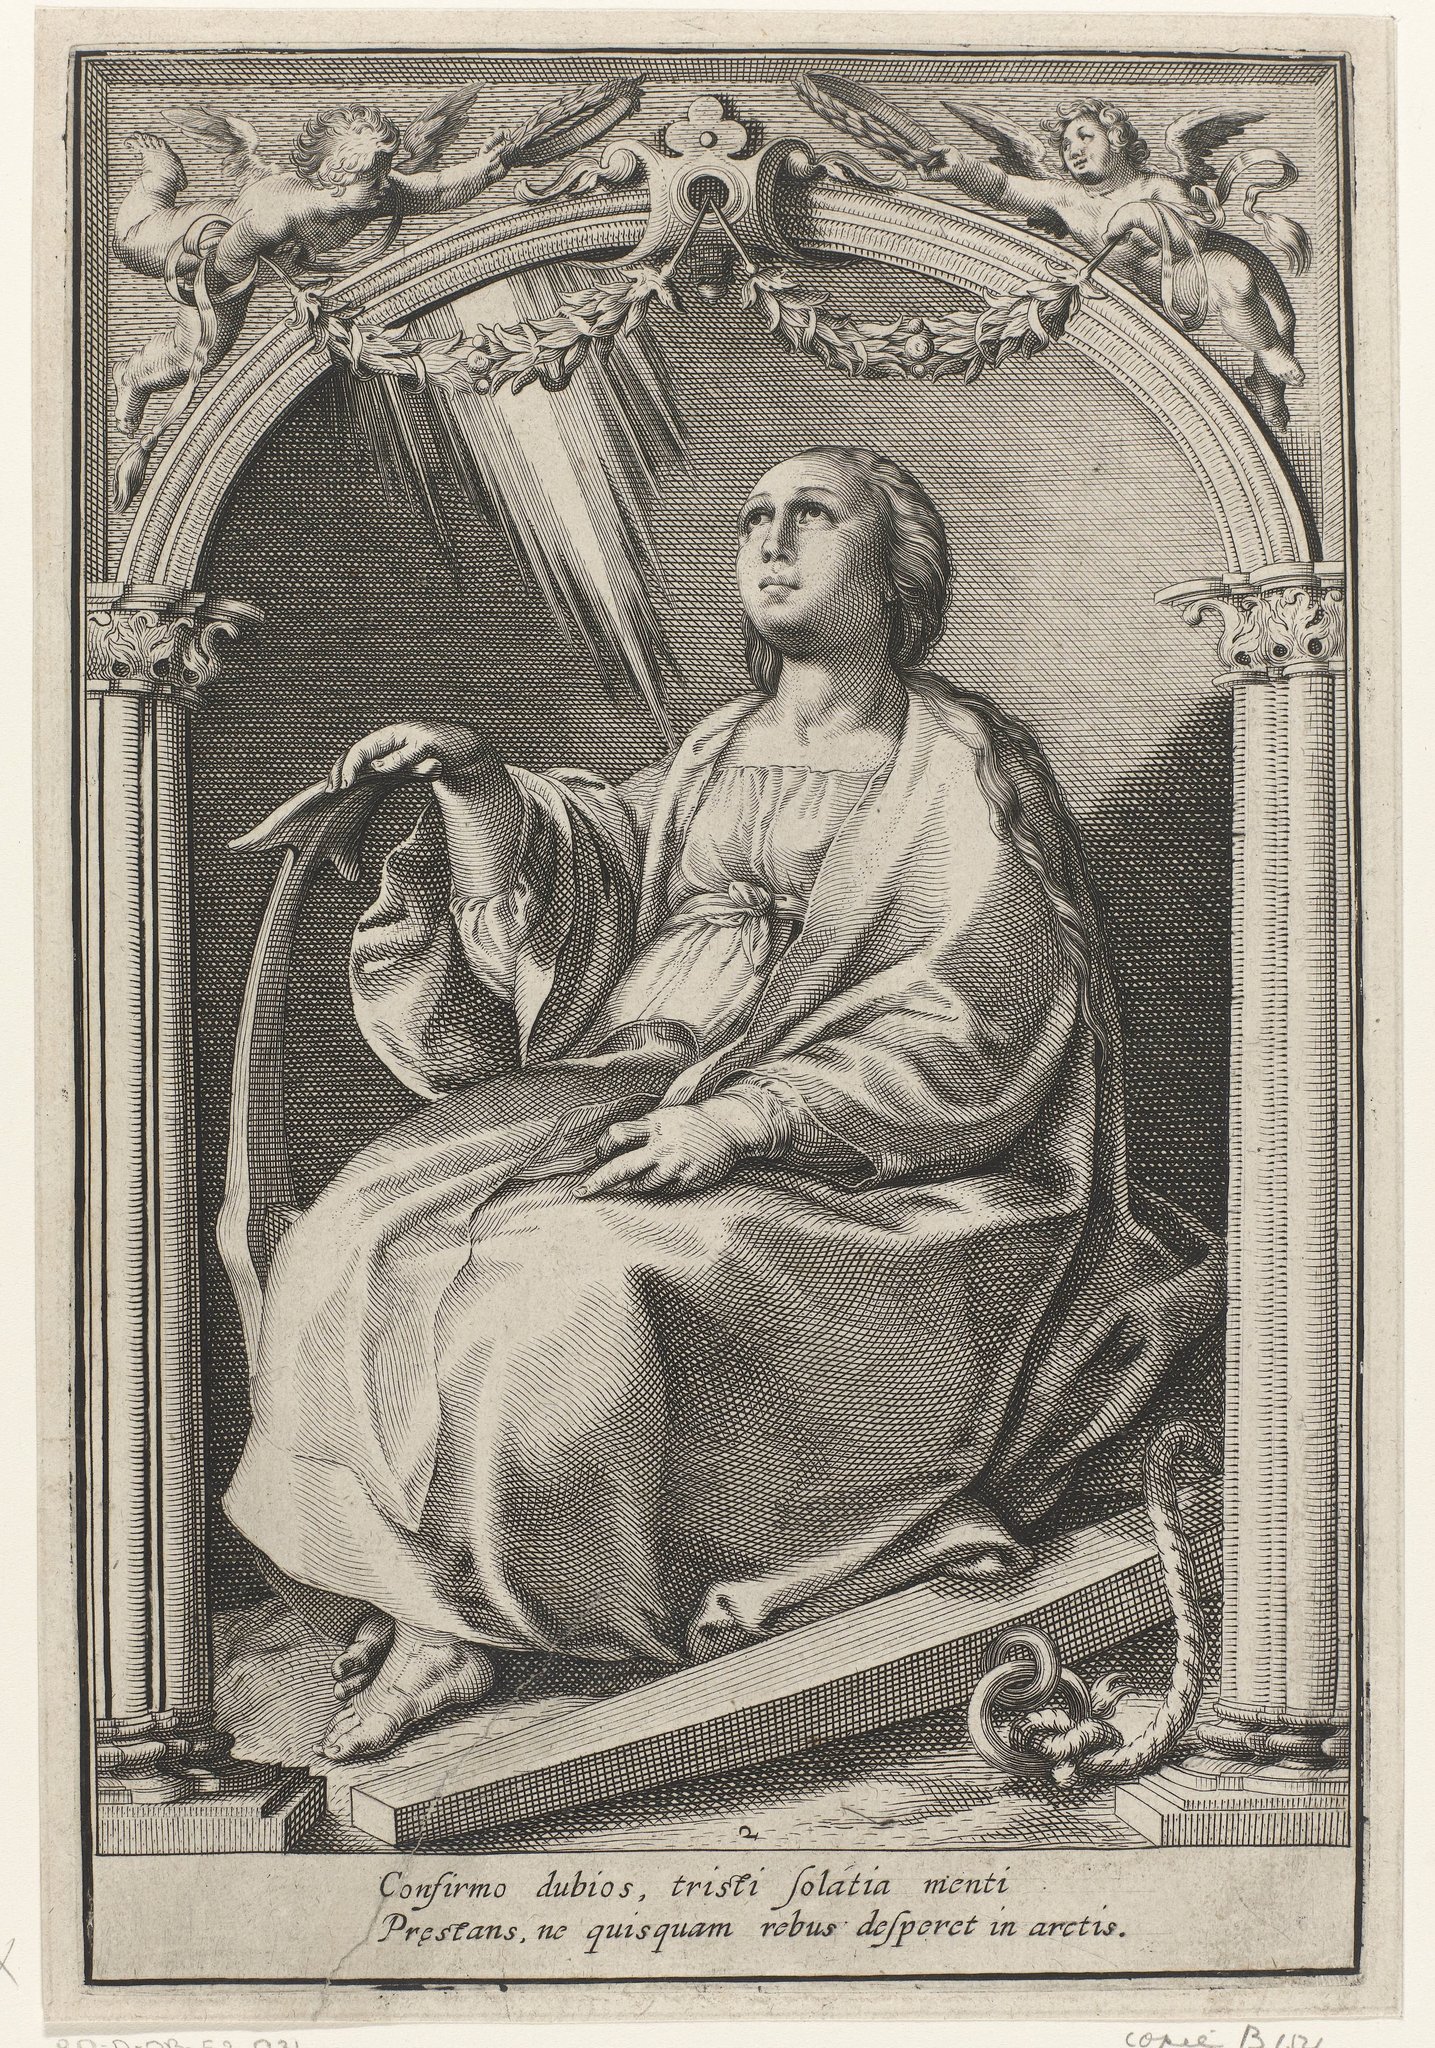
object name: print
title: De drie goddelijke deugden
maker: Anonymous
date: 1592-1667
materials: paper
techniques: engraving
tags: hope, 'spes'; 'speranza divina e certa' (ripa) ~ one of the three theological virtues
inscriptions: collector's mark: Lugt 240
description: De personificatie van de Hoop, een van de drie goddelijke deugden, kijkt op naar de hemel rustend op een anker. De voorstelling wordt omvat door een ornamentele boog met putti met lauwerkransen en guirlandes. Onder de voorstelling een tweeregelige tekst in het Latijn.